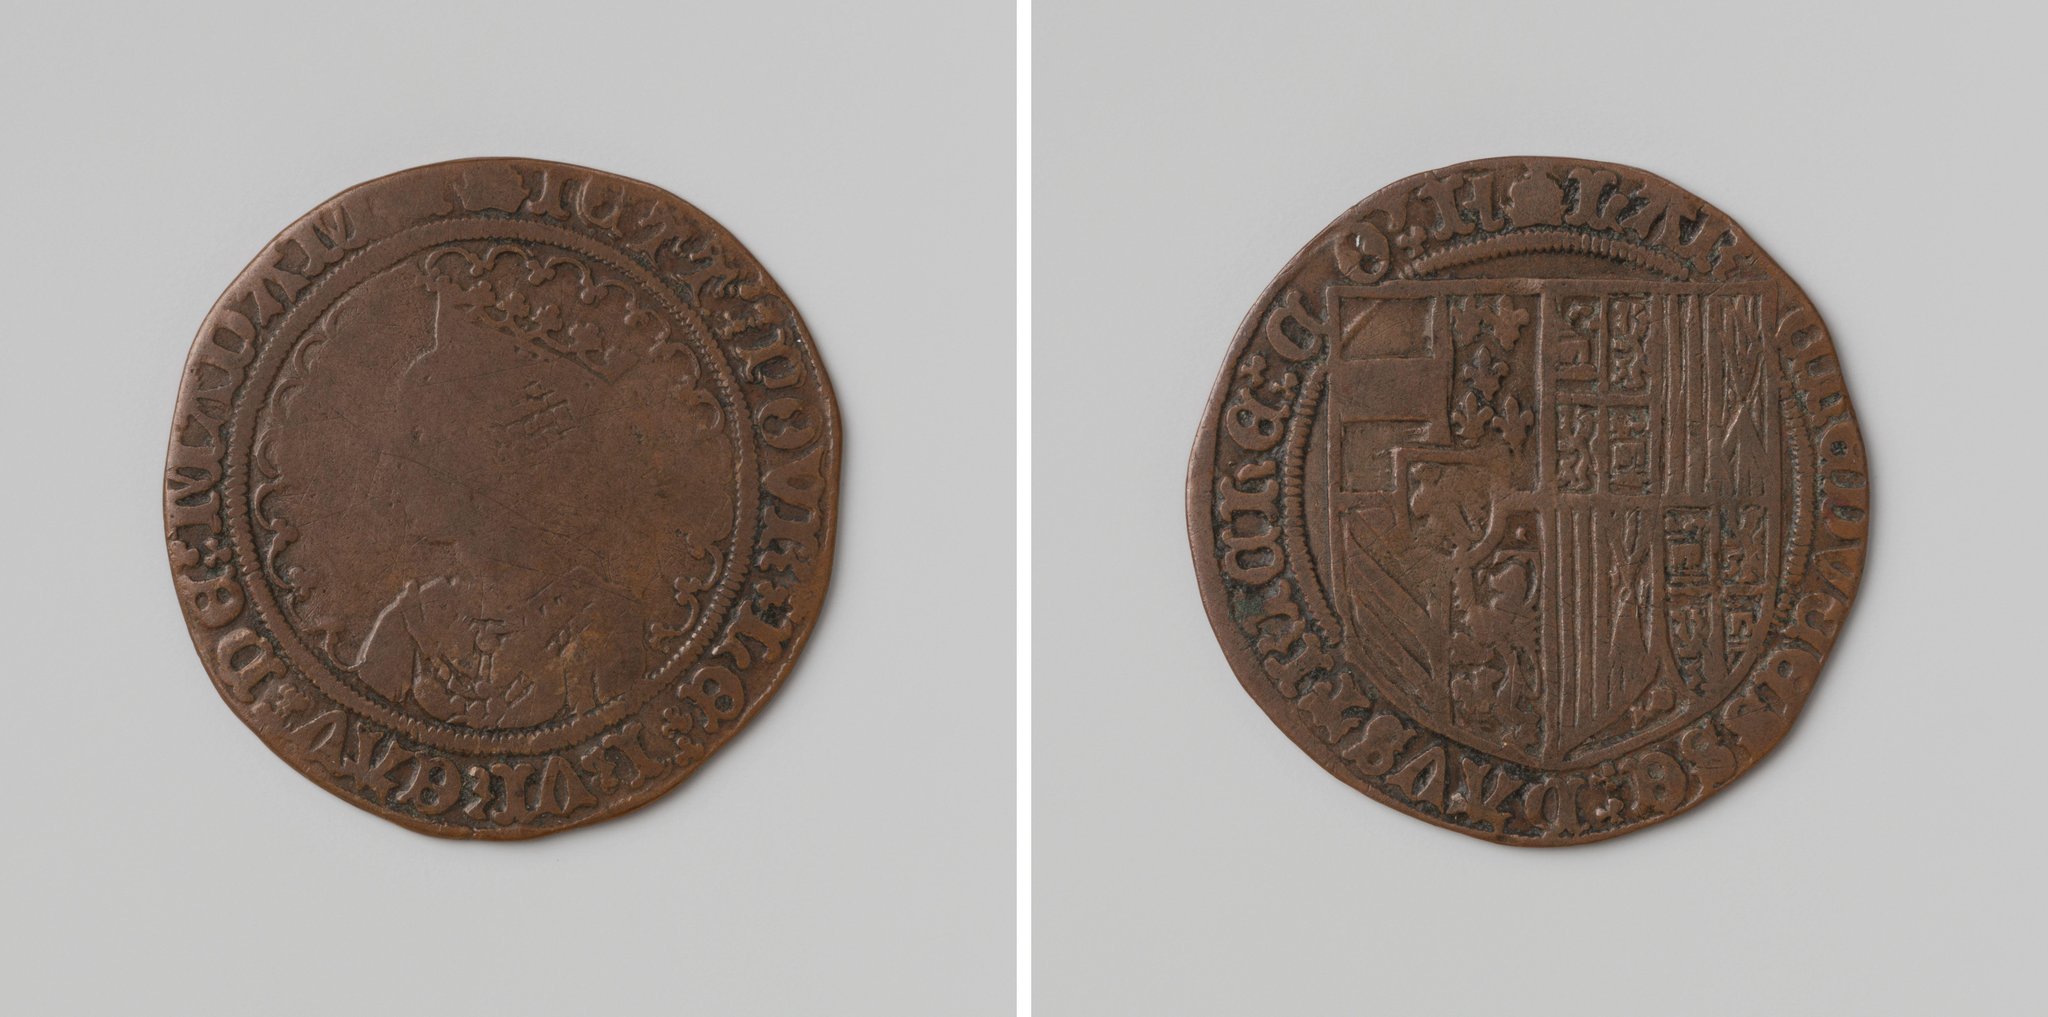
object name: jeton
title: Huwelijk van Filips de Schone, hertog van Bourgondie met Johanna, prinses van Castillie, rekenpenning van het bureau van de aartshertogin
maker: Anonymous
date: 1496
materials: copper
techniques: striking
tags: bruges, filips de schone (hertog van bourgondië)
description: Koperen penning. Voorzijde: borststuk van gekroonde vrouw binnen omschrift. Keerzijde: wapenschild binnen omschrift